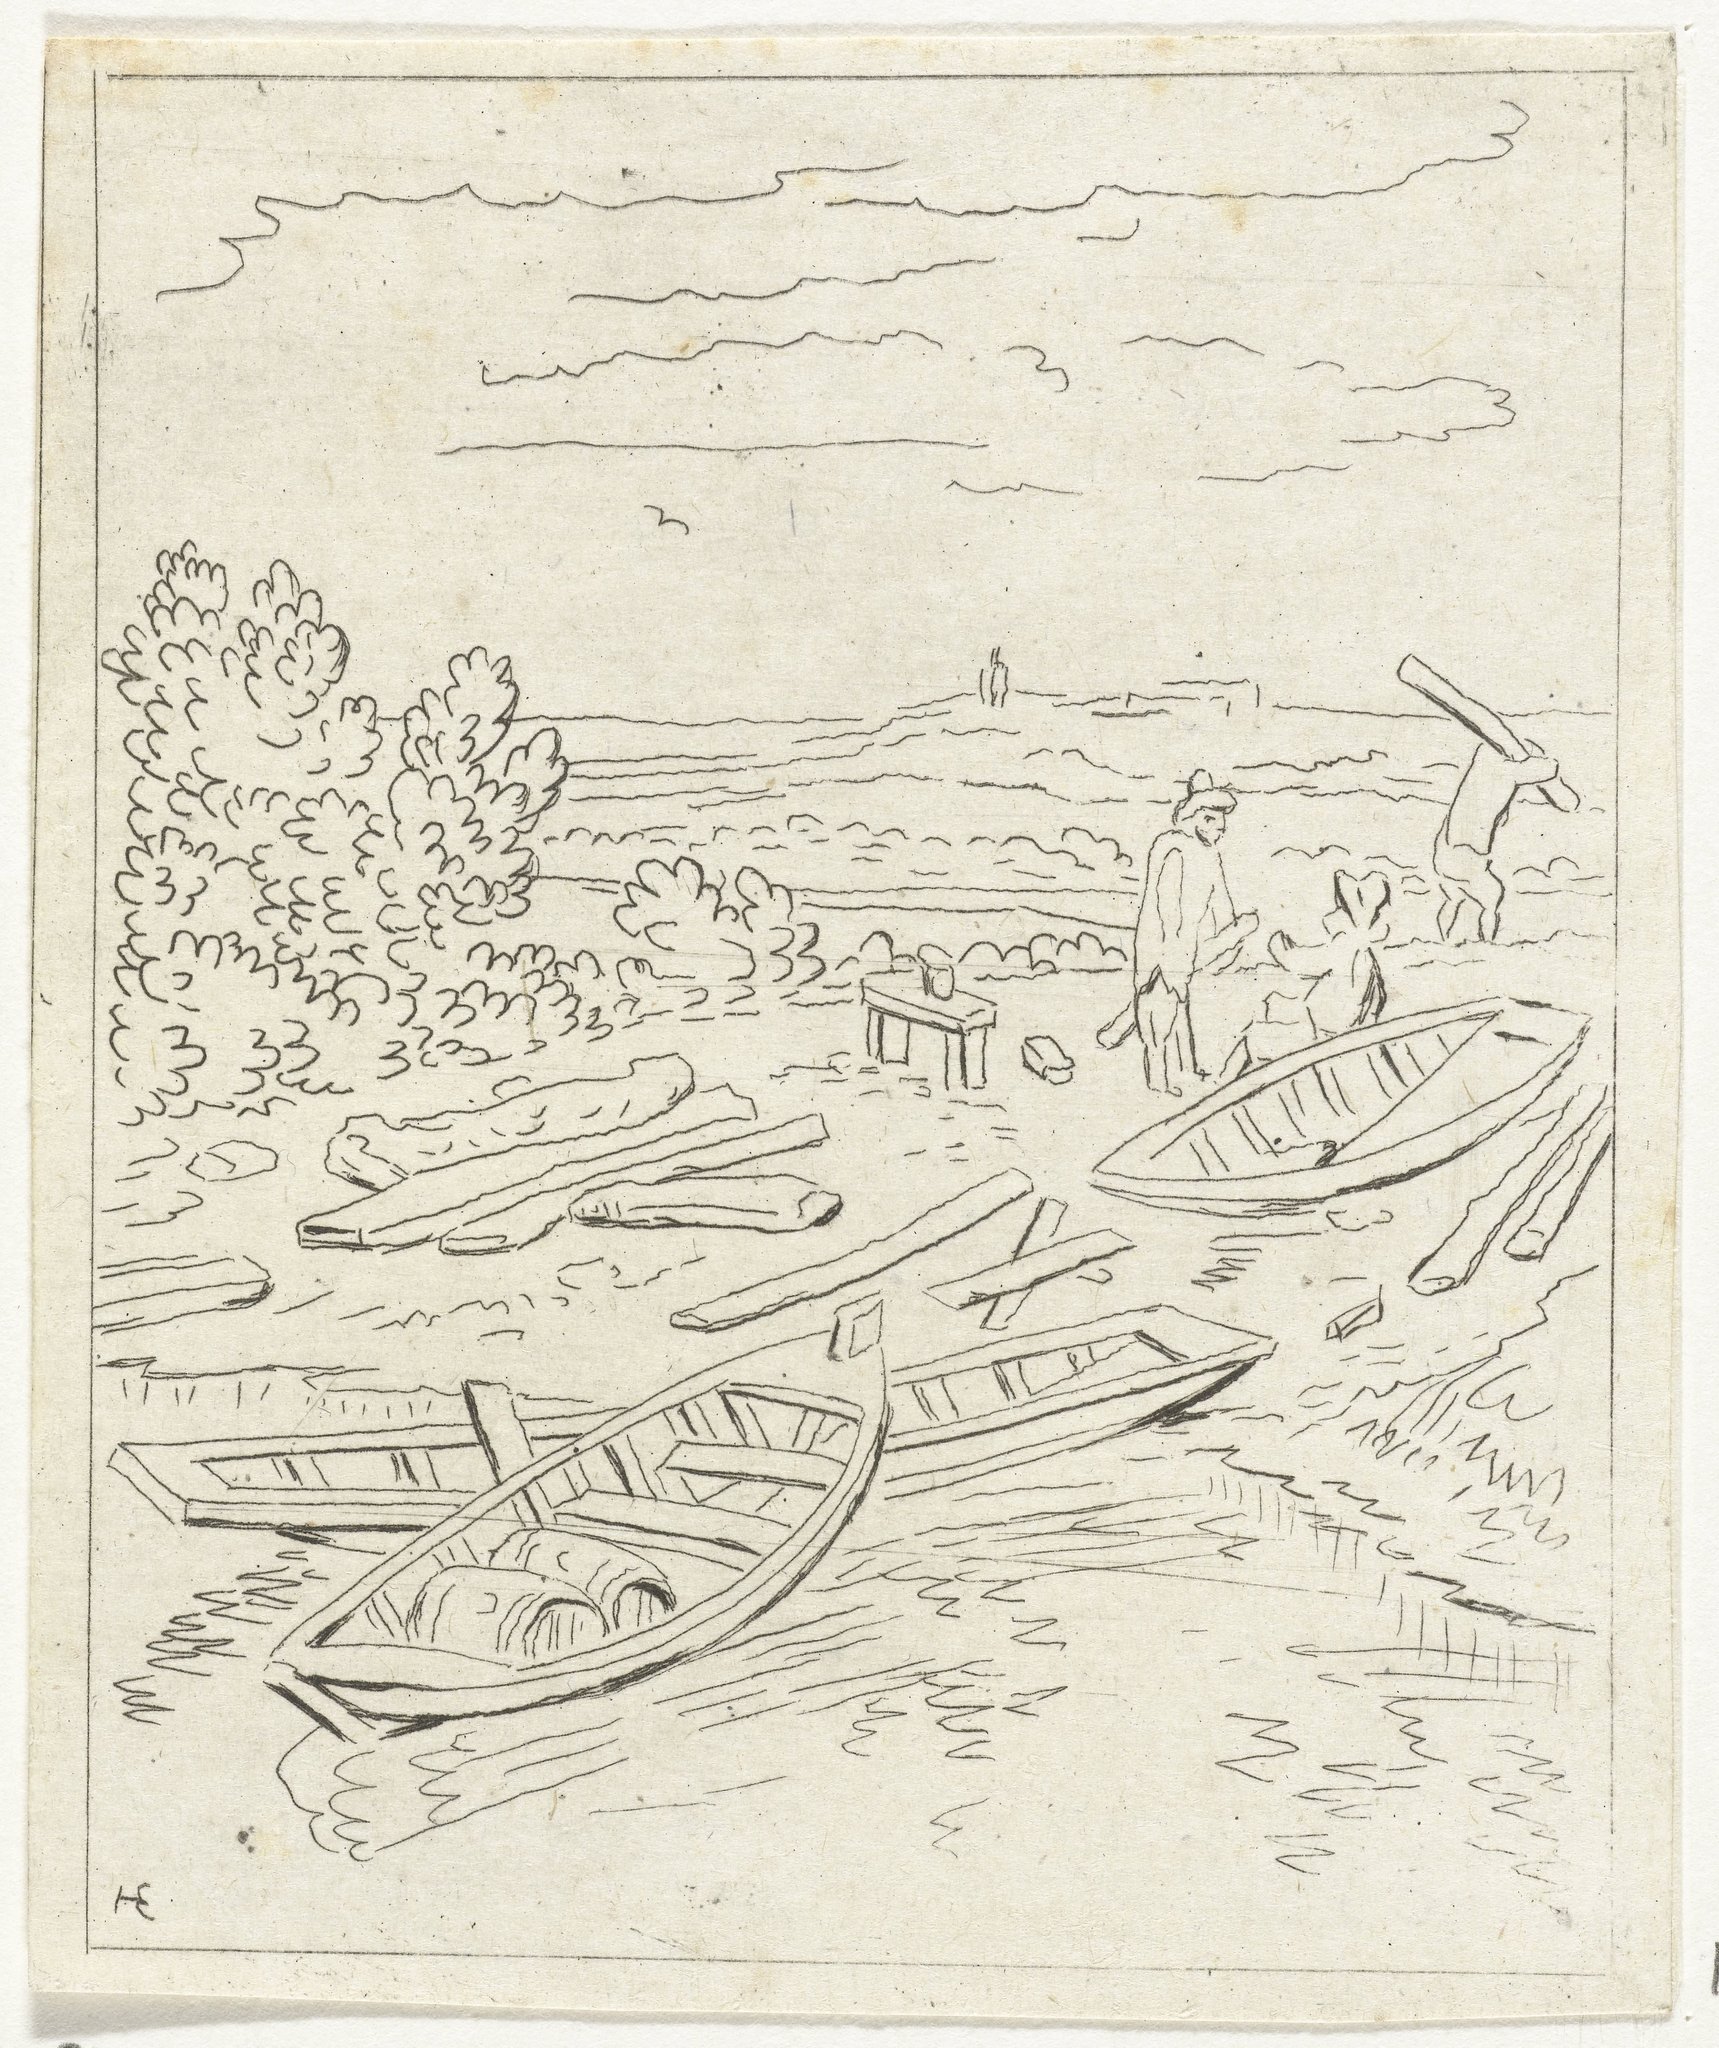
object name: print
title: Roeiboten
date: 1778-1838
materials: paper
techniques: etching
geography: netherlands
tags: shipyard, shipdock - cc - more than one ship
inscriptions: collector's mark: Lugt 2228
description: Drie lege boten liggen langs de oever bij een werft. Twee mannen staan bij een van de boten te praten, een derde man draagt een stuk hout op zijn rug en loopt weg. In een van de boten liggen twee houten vaten.